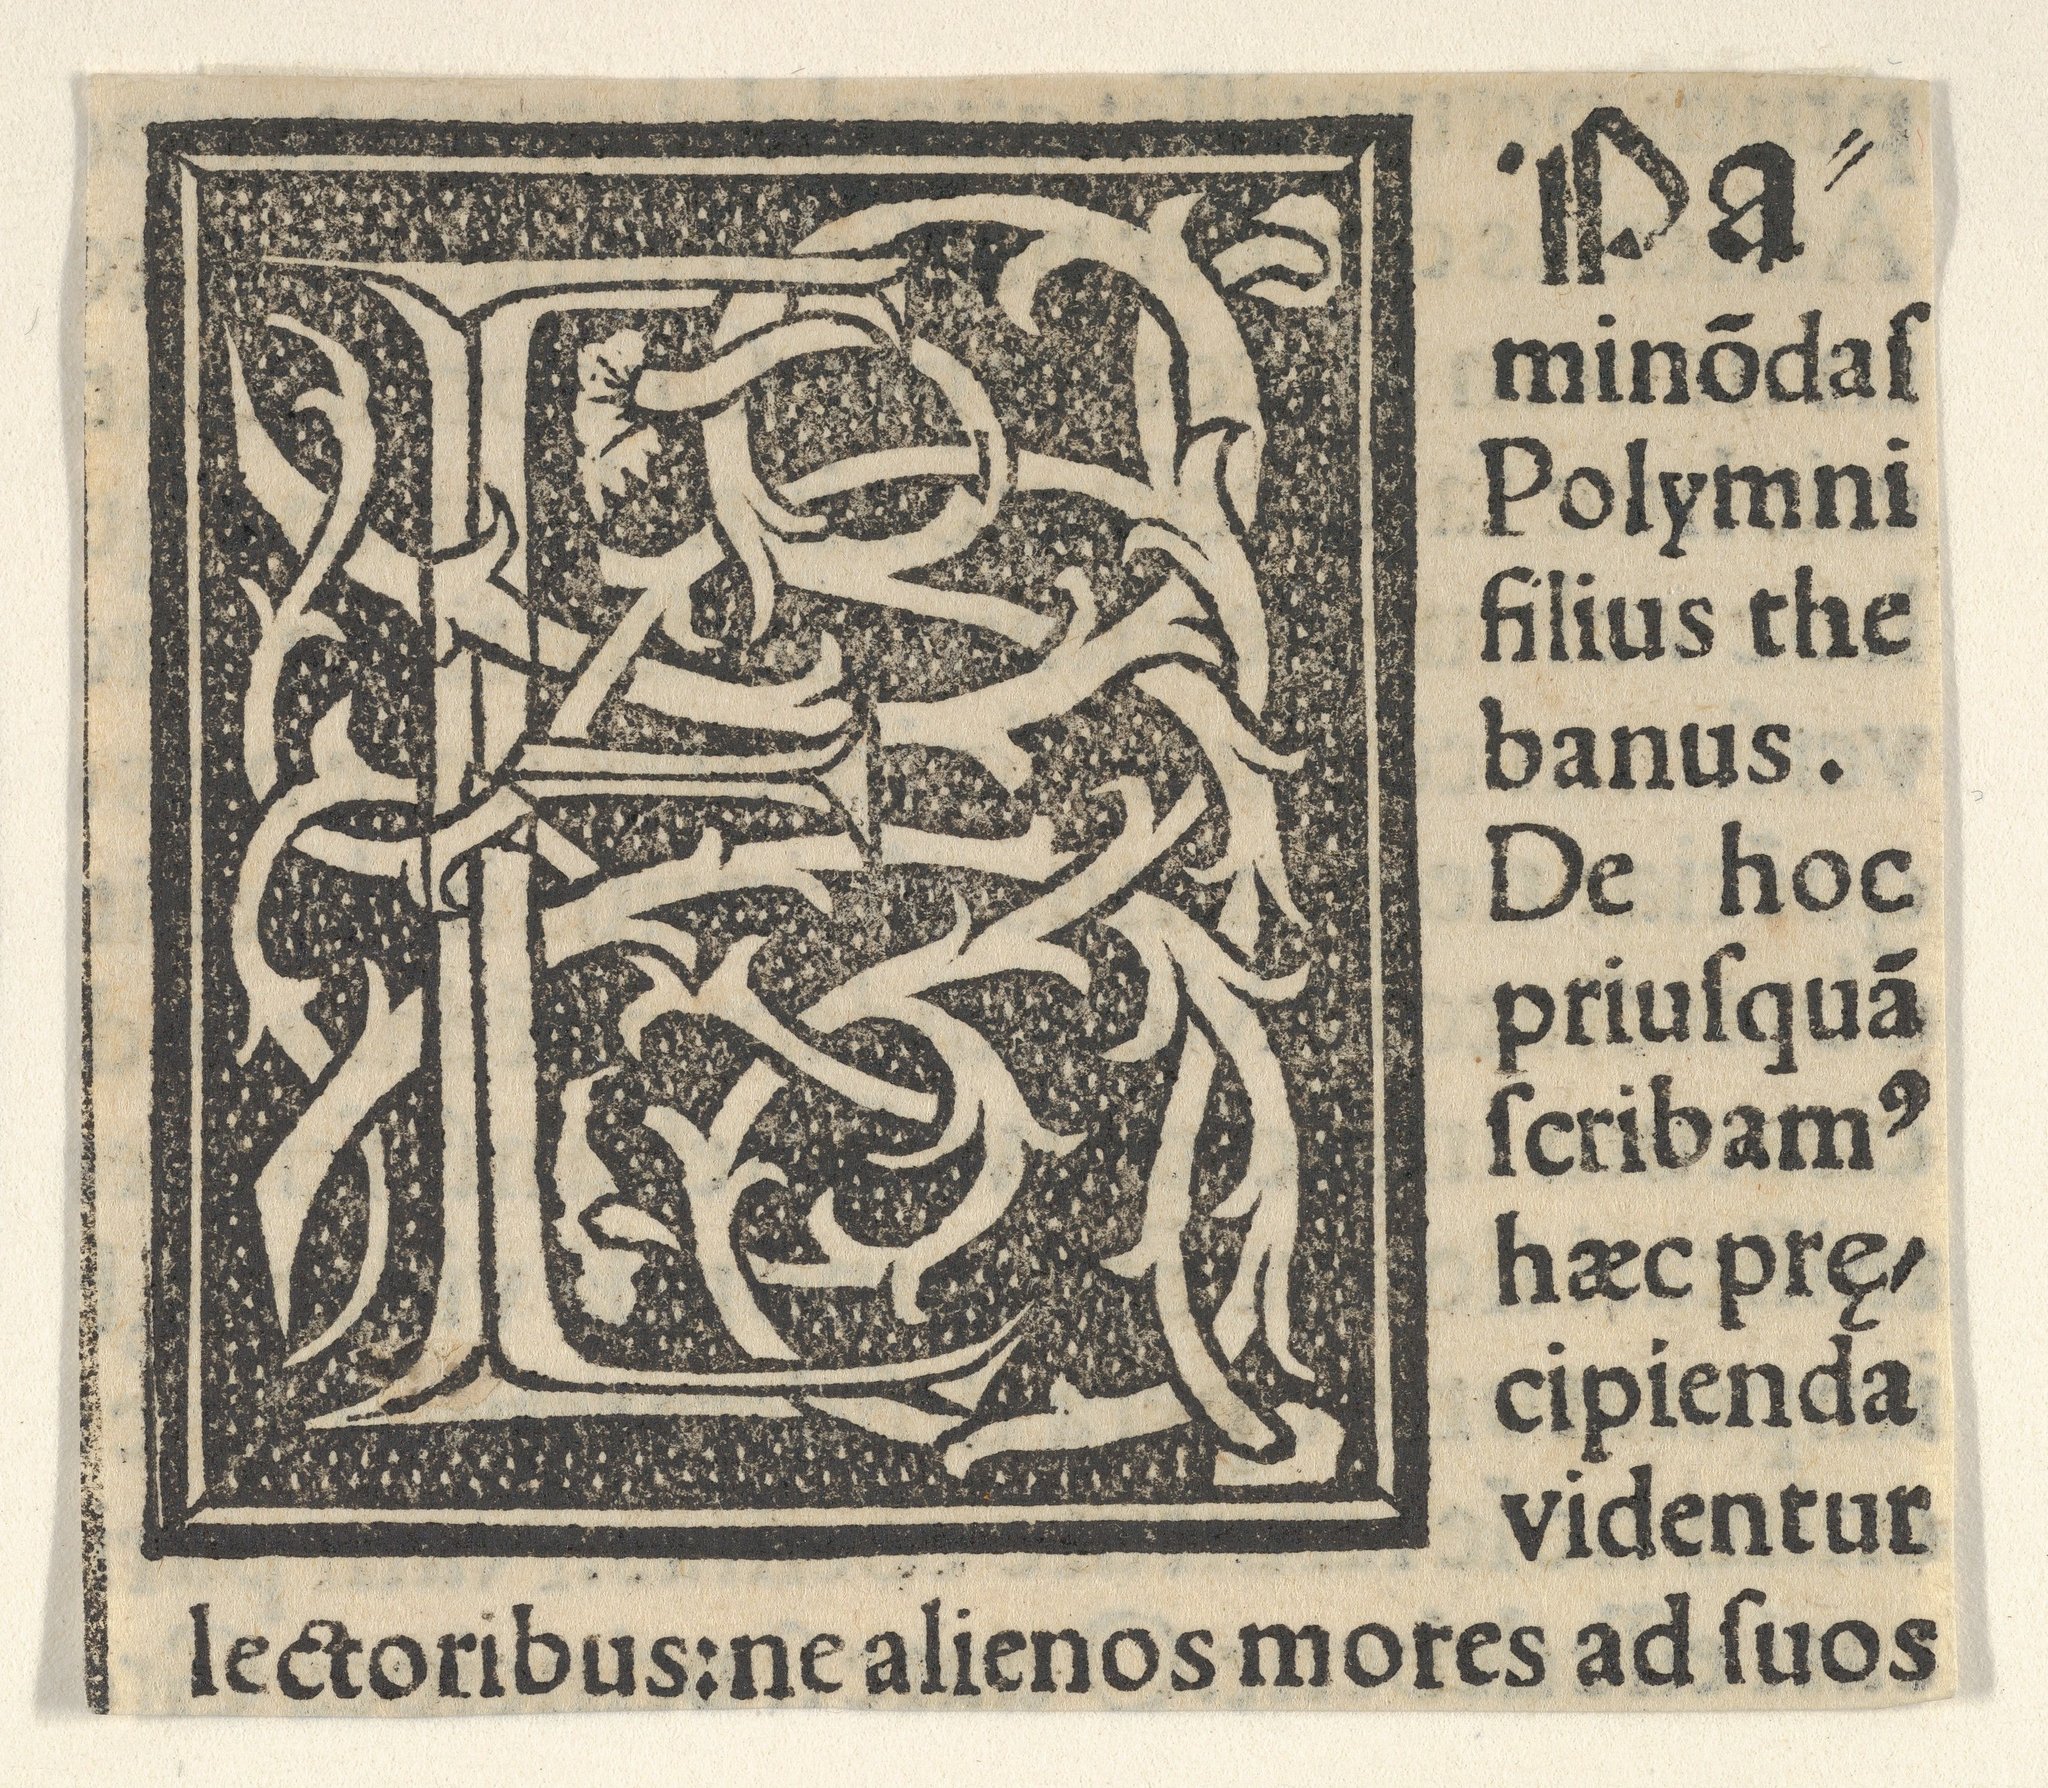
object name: print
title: Initial letter E on patterned background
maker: anonymous, italian, 16th century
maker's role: artist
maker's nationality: italian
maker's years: 1500-1600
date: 1520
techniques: woodcut